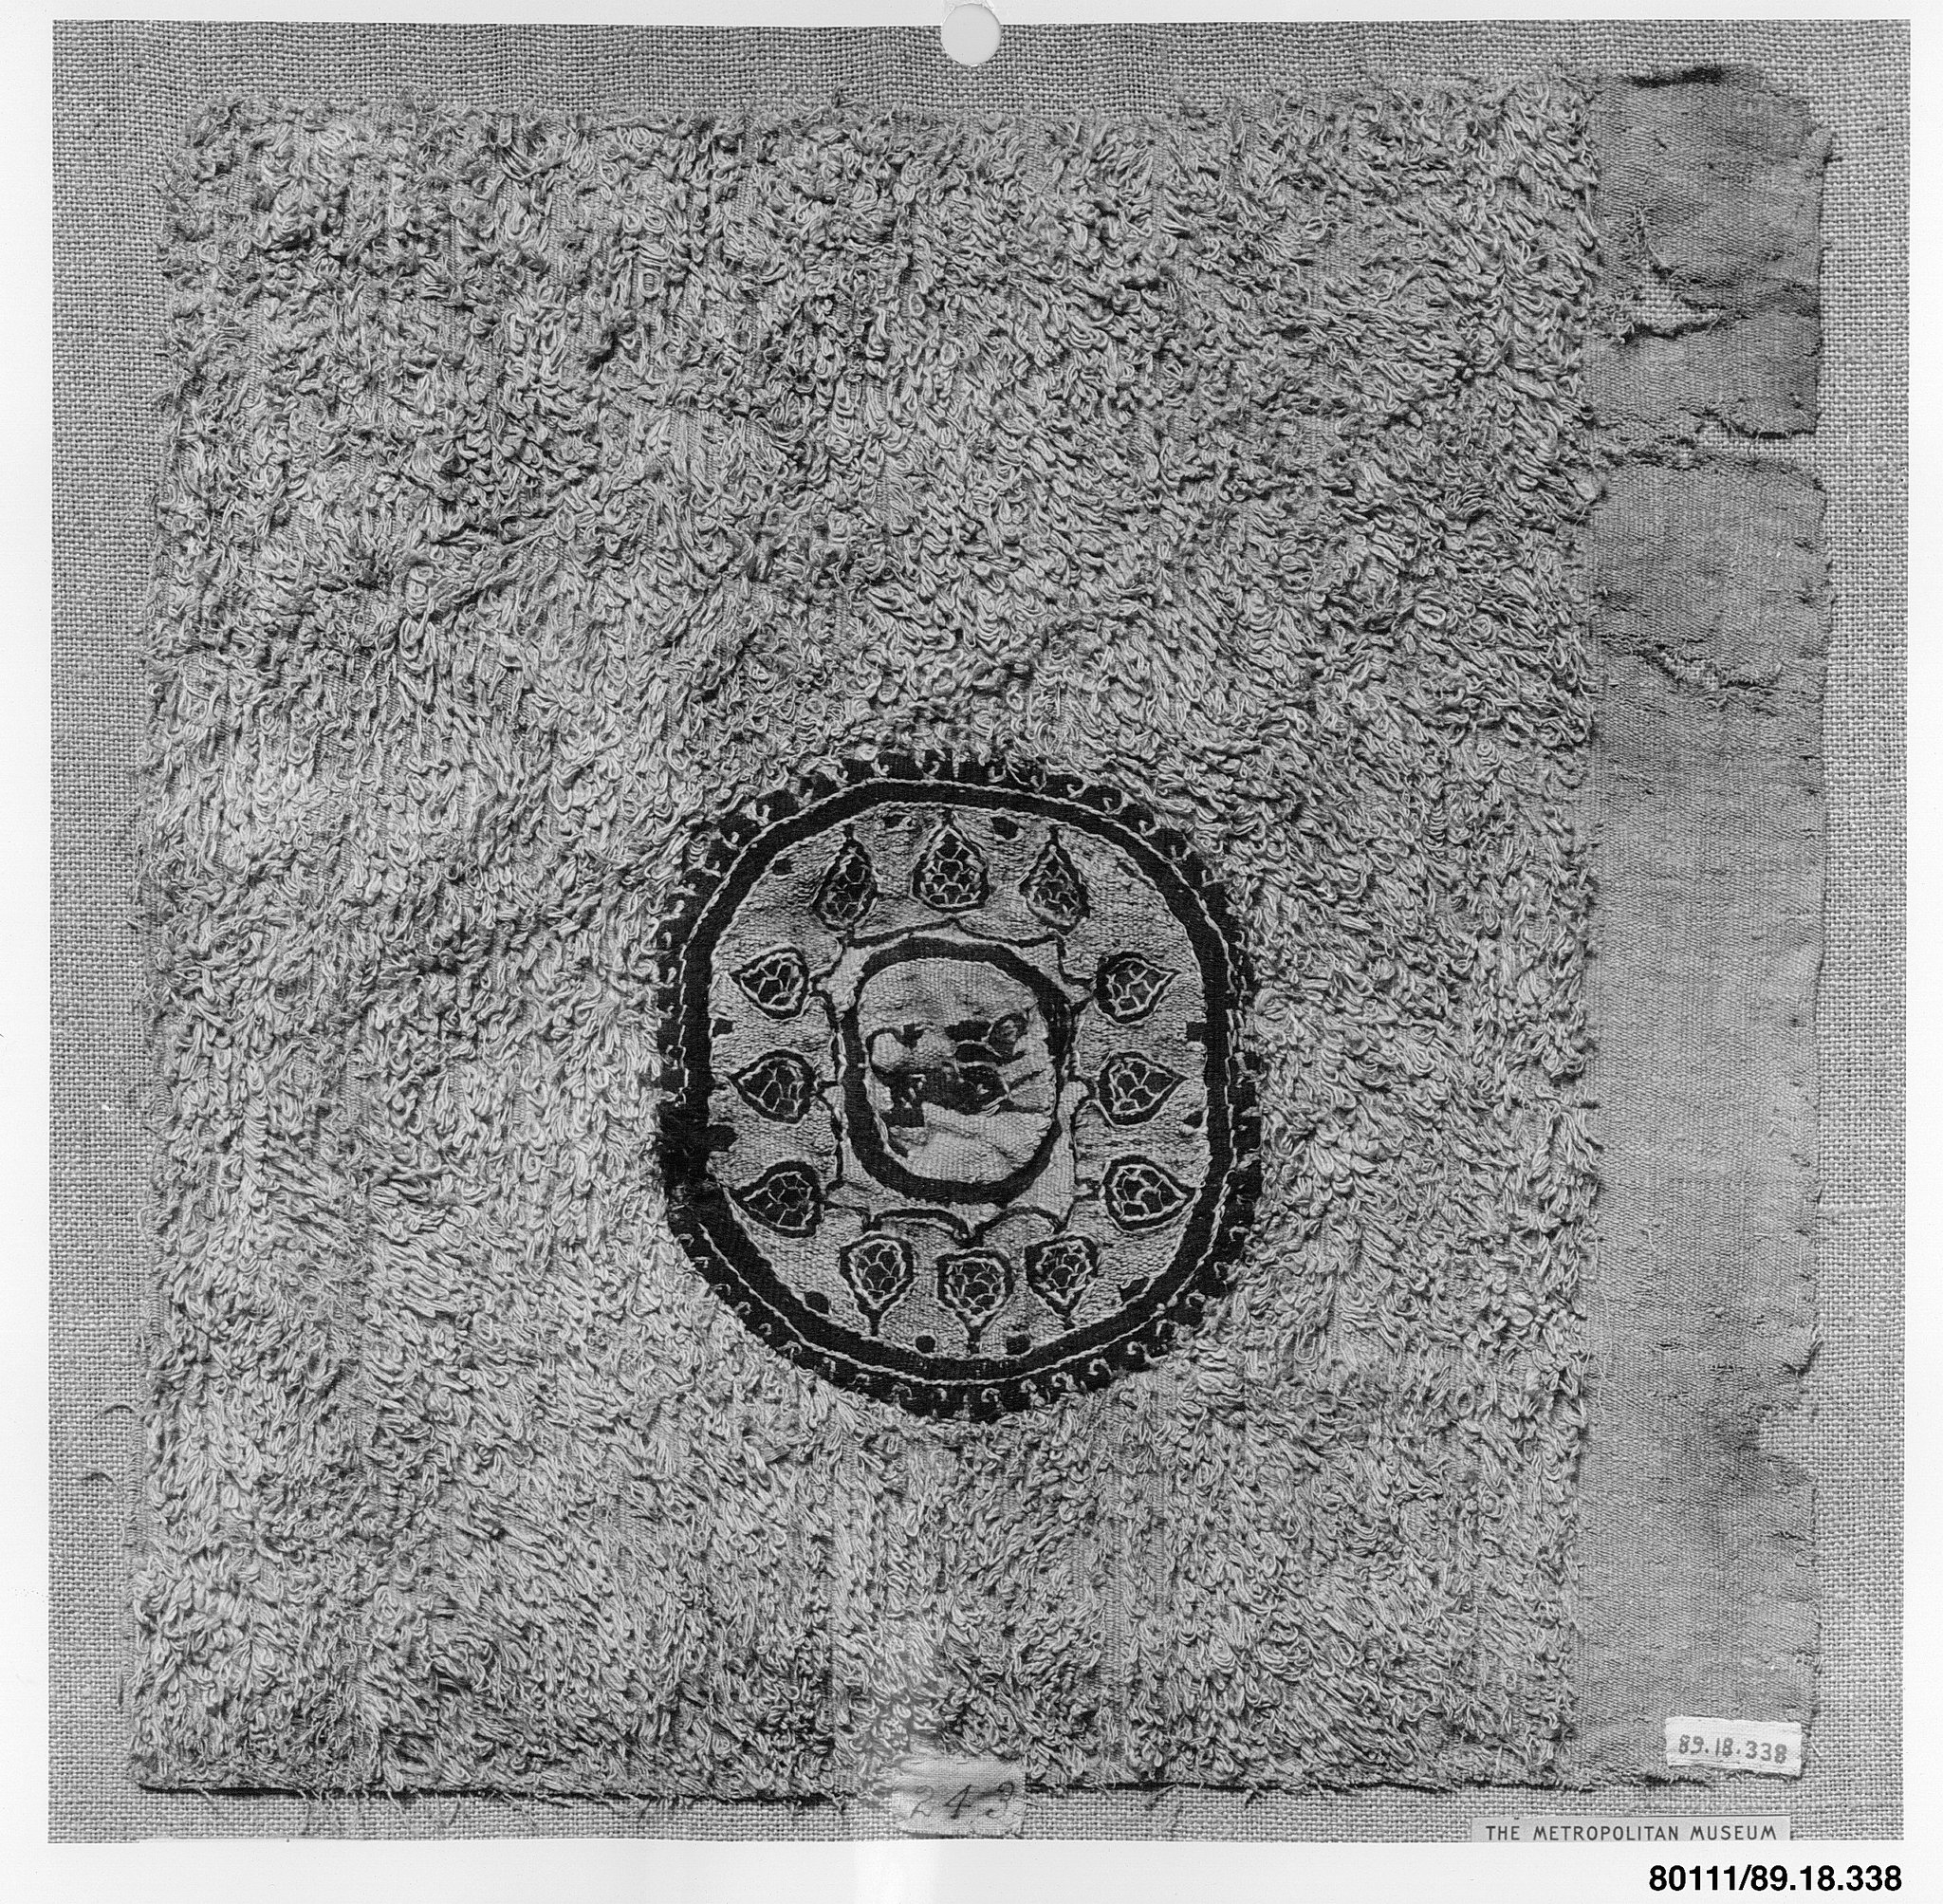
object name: textile fragment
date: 201-400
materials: linen, wool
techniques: weave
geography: egypt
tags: animals